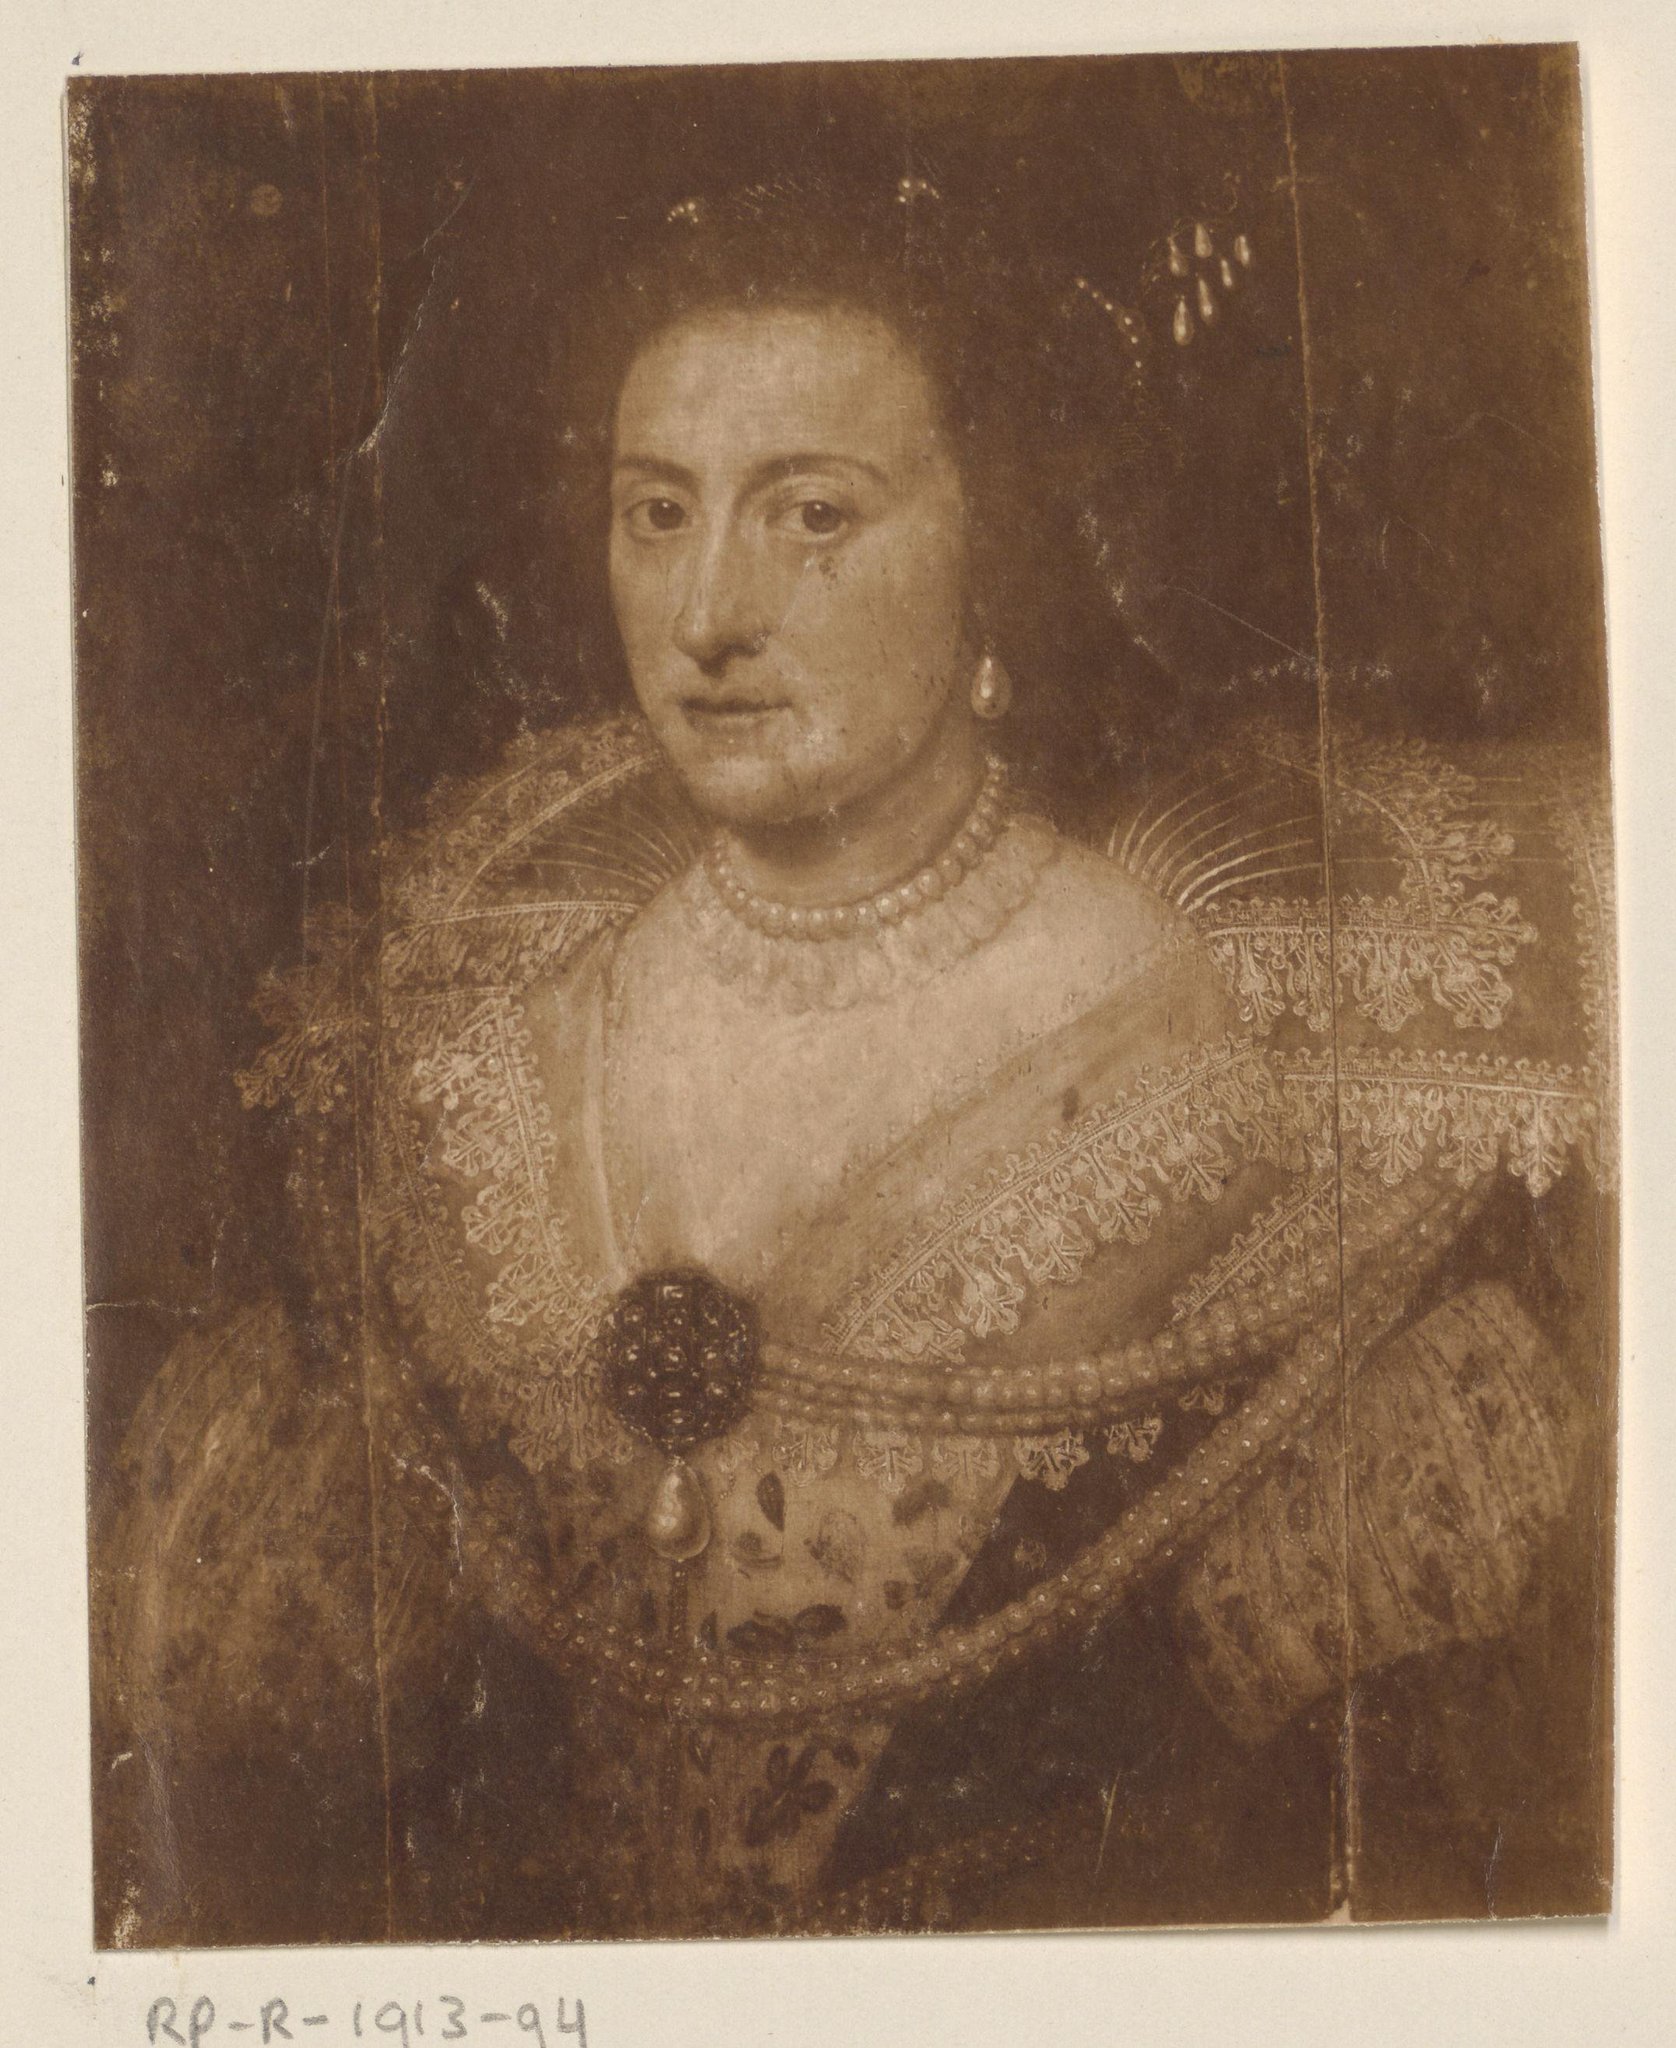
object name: reproduction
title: Portret van Elisabeth Stuart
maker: Anonymous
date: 1885-1913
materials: paper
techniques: gelatin silver print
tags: london, historical persons - bb - woman, queen, pearl; pearl necklace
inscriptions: collector's mark: Lugt 2228